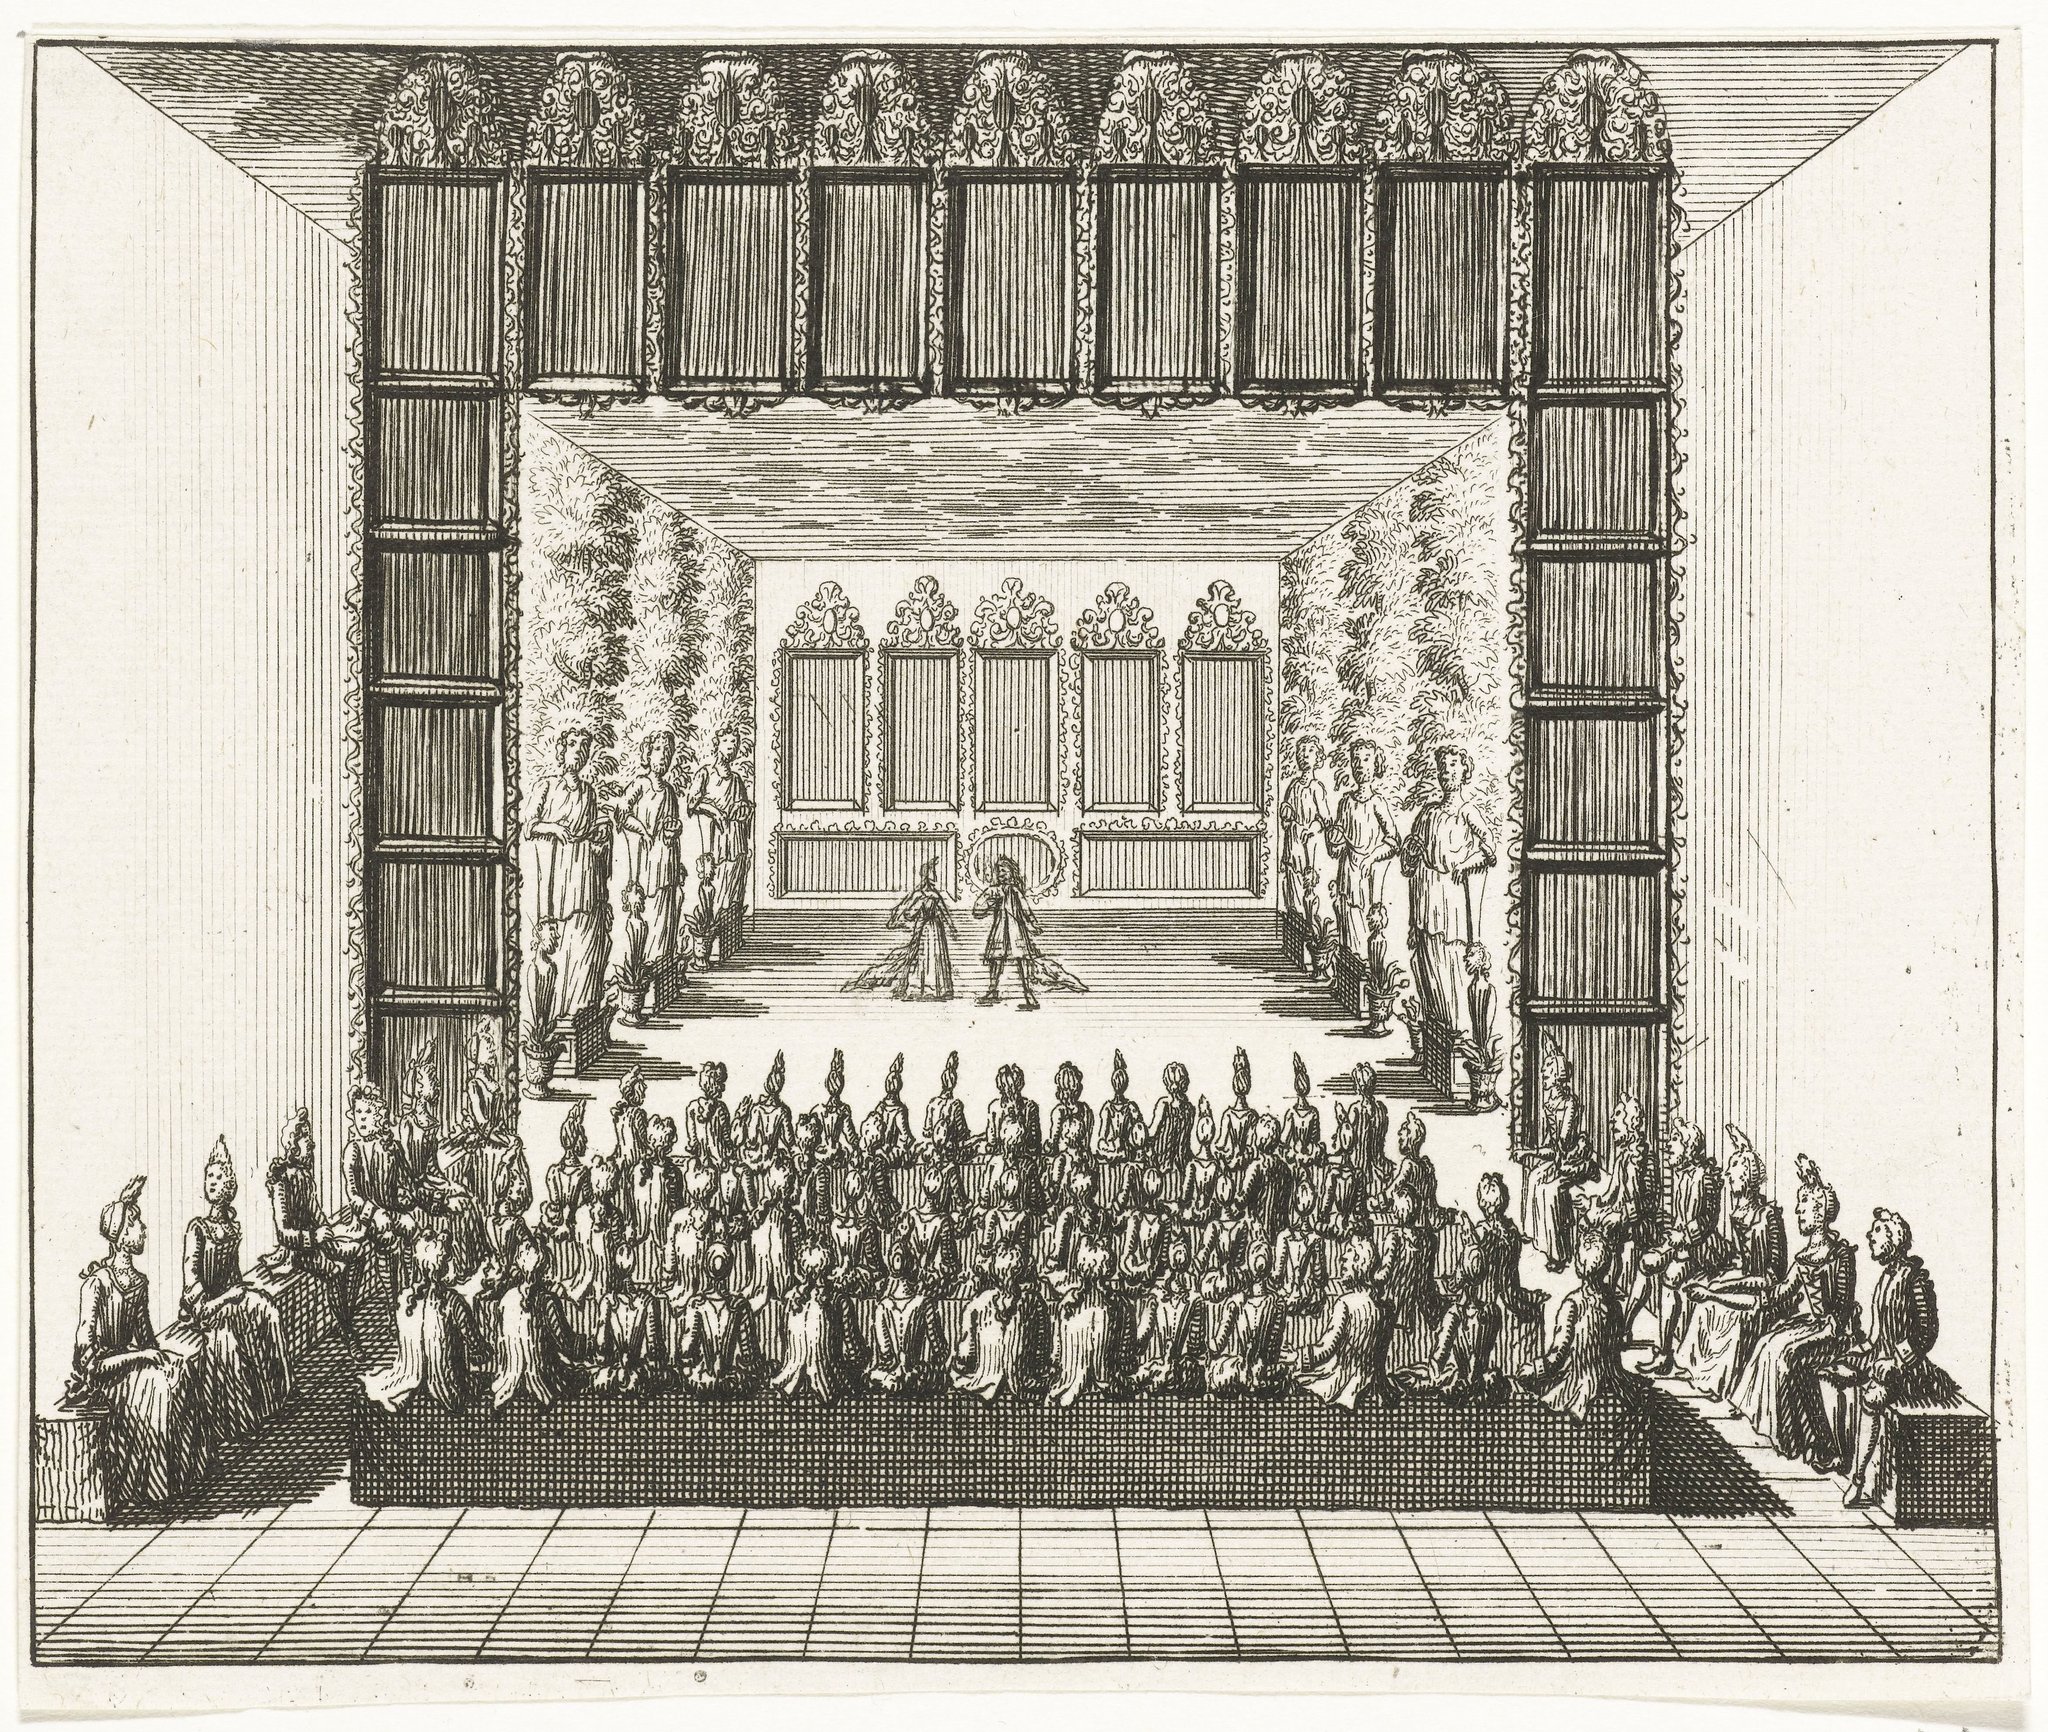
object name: print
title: Toneelvoorstelling, 1714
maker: Anonymous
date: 1714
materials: paper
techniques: etching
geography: northern netherlands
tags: vienna, public festivities at birth of royal persons, theatre, theatrical performance, utrecht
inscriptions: collector's mark: Lugt 2228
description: Toneelvoorstelling, 1714. Onderdeel van een groep van twaalf illustraties van de feestelijkheden georganiseerd in Utrecht in 1714 door de Portugese graaf Joao Gomes da Silva conde de Tarouca ter ere van de geboorte van twee Portugese prinsjes van koning Johan V.